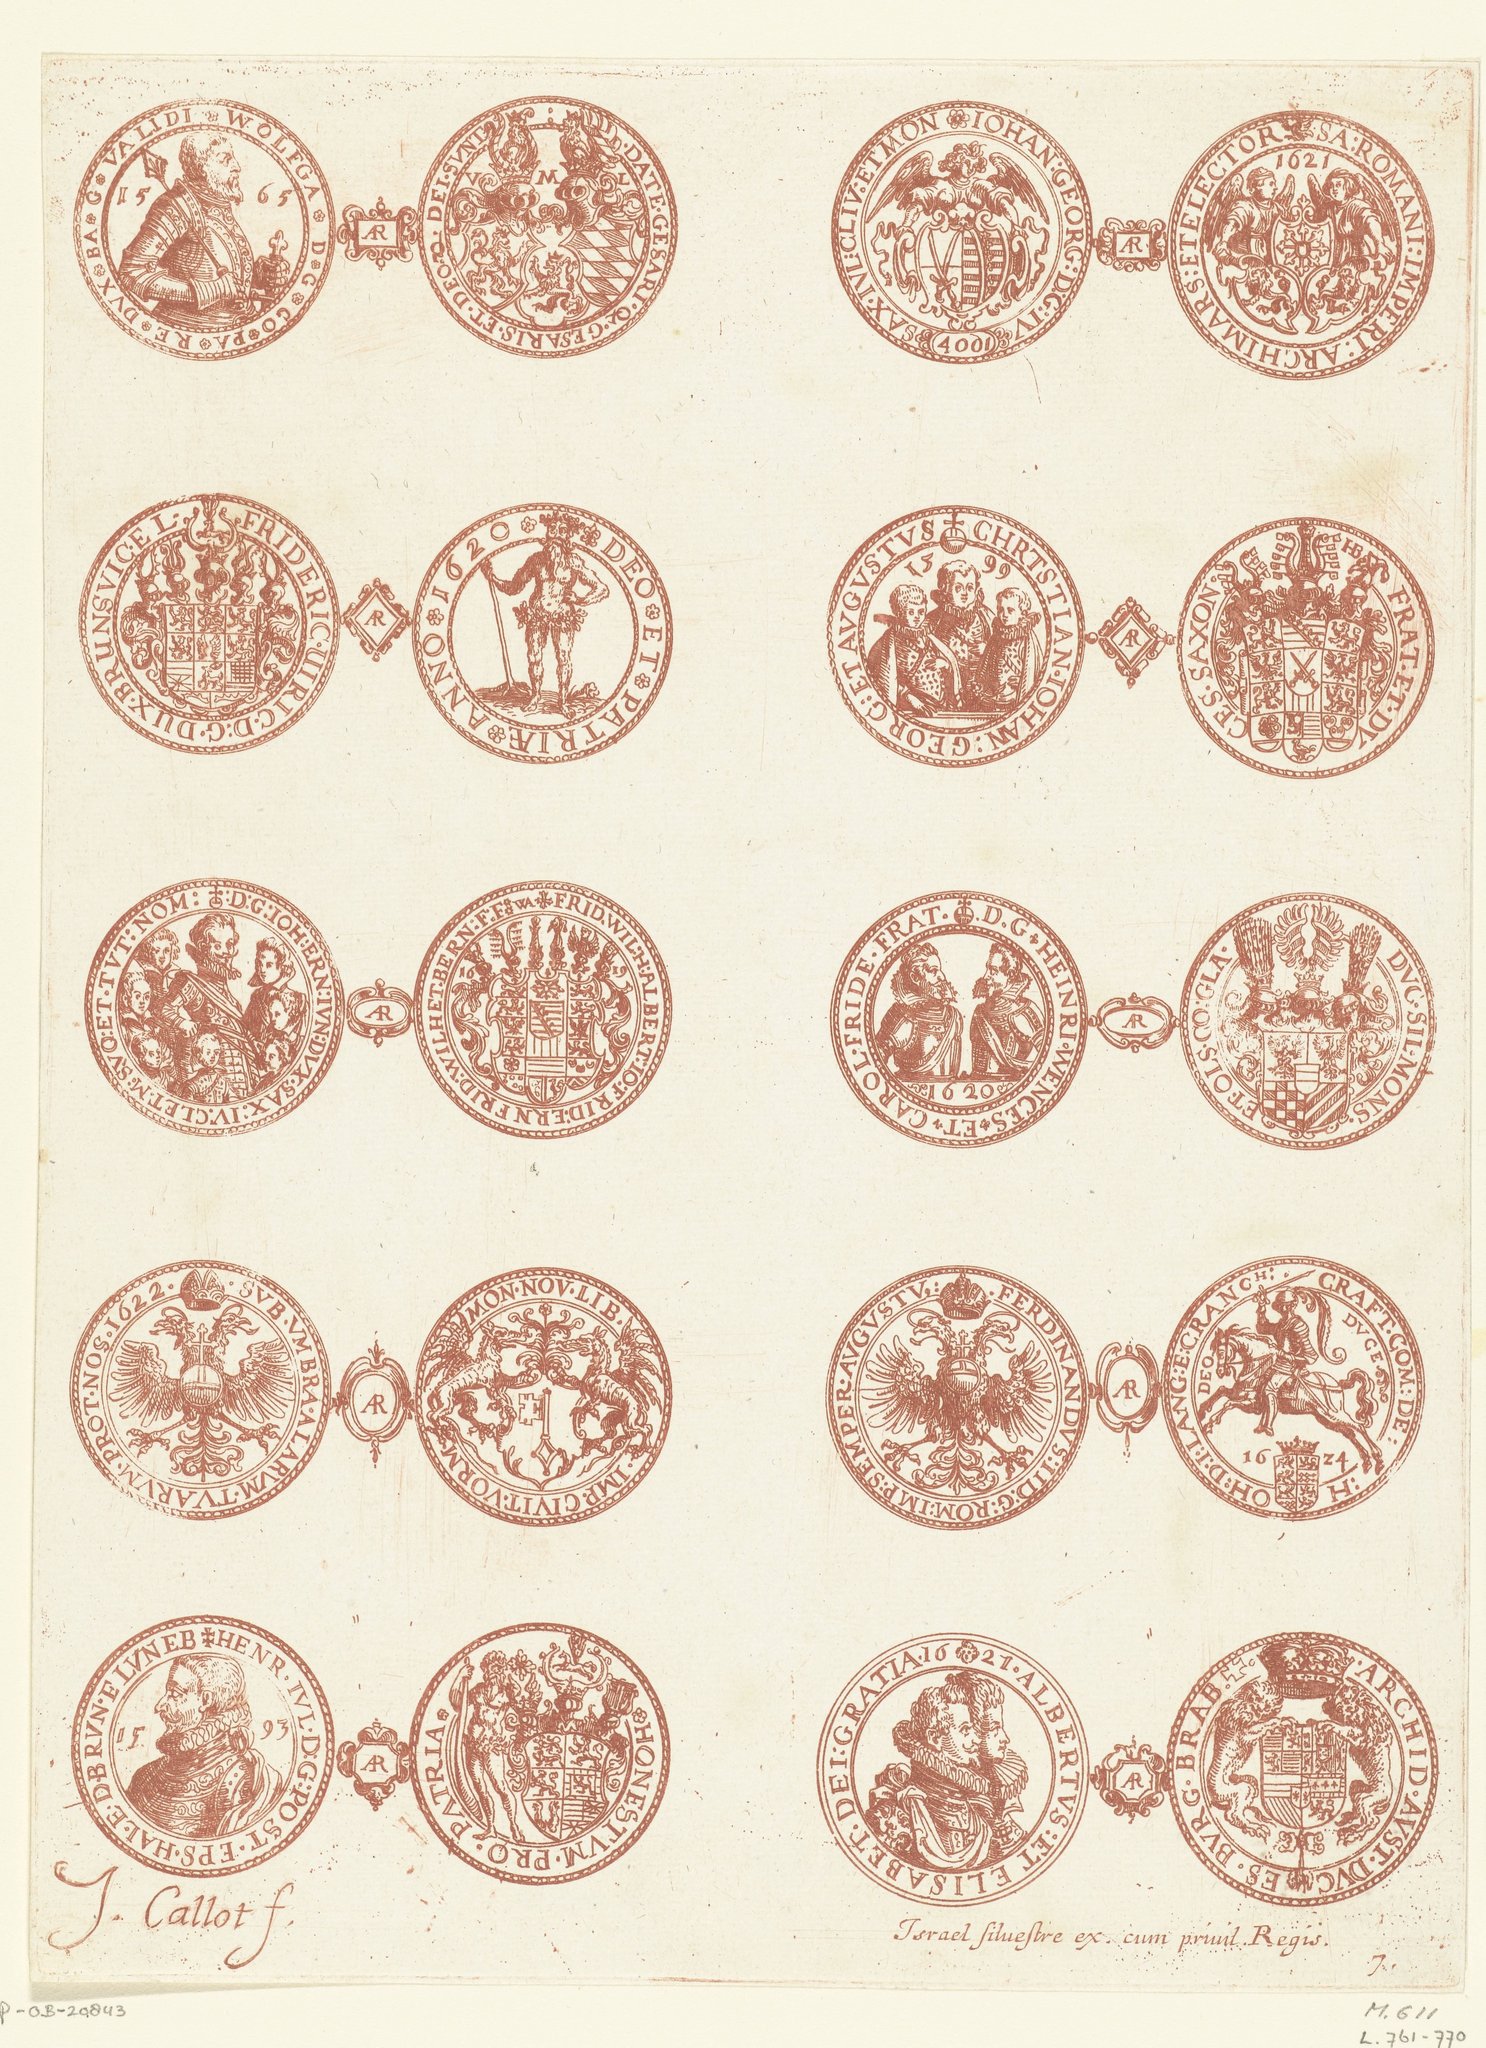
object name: print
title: Tien Europese munten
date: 1629-1630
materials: paper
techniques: etching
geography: nancy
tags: coin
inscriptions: collector's mark: Lugt 240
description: Tien Europese munten, in twee kolommen van vijf afgebeeld. Deze prent is onderdeel van een serie van tien prenten met voorstellingen van munten die tussen 1522 en 1629 in omloop gebracht zijn in Europa, voornamelijk in Duitsland en Italië. Van elke munt zijn de voor- en achterzijde naast elkaar weergegeven, verbonden door een cartouche met de letters AR (argentum - zilver) of AV (aureum - goud). De zilveren munten beslaan de eerste negen bladen en een deel van het tiende blad, dat verder voornamelijk gouden munten toont.